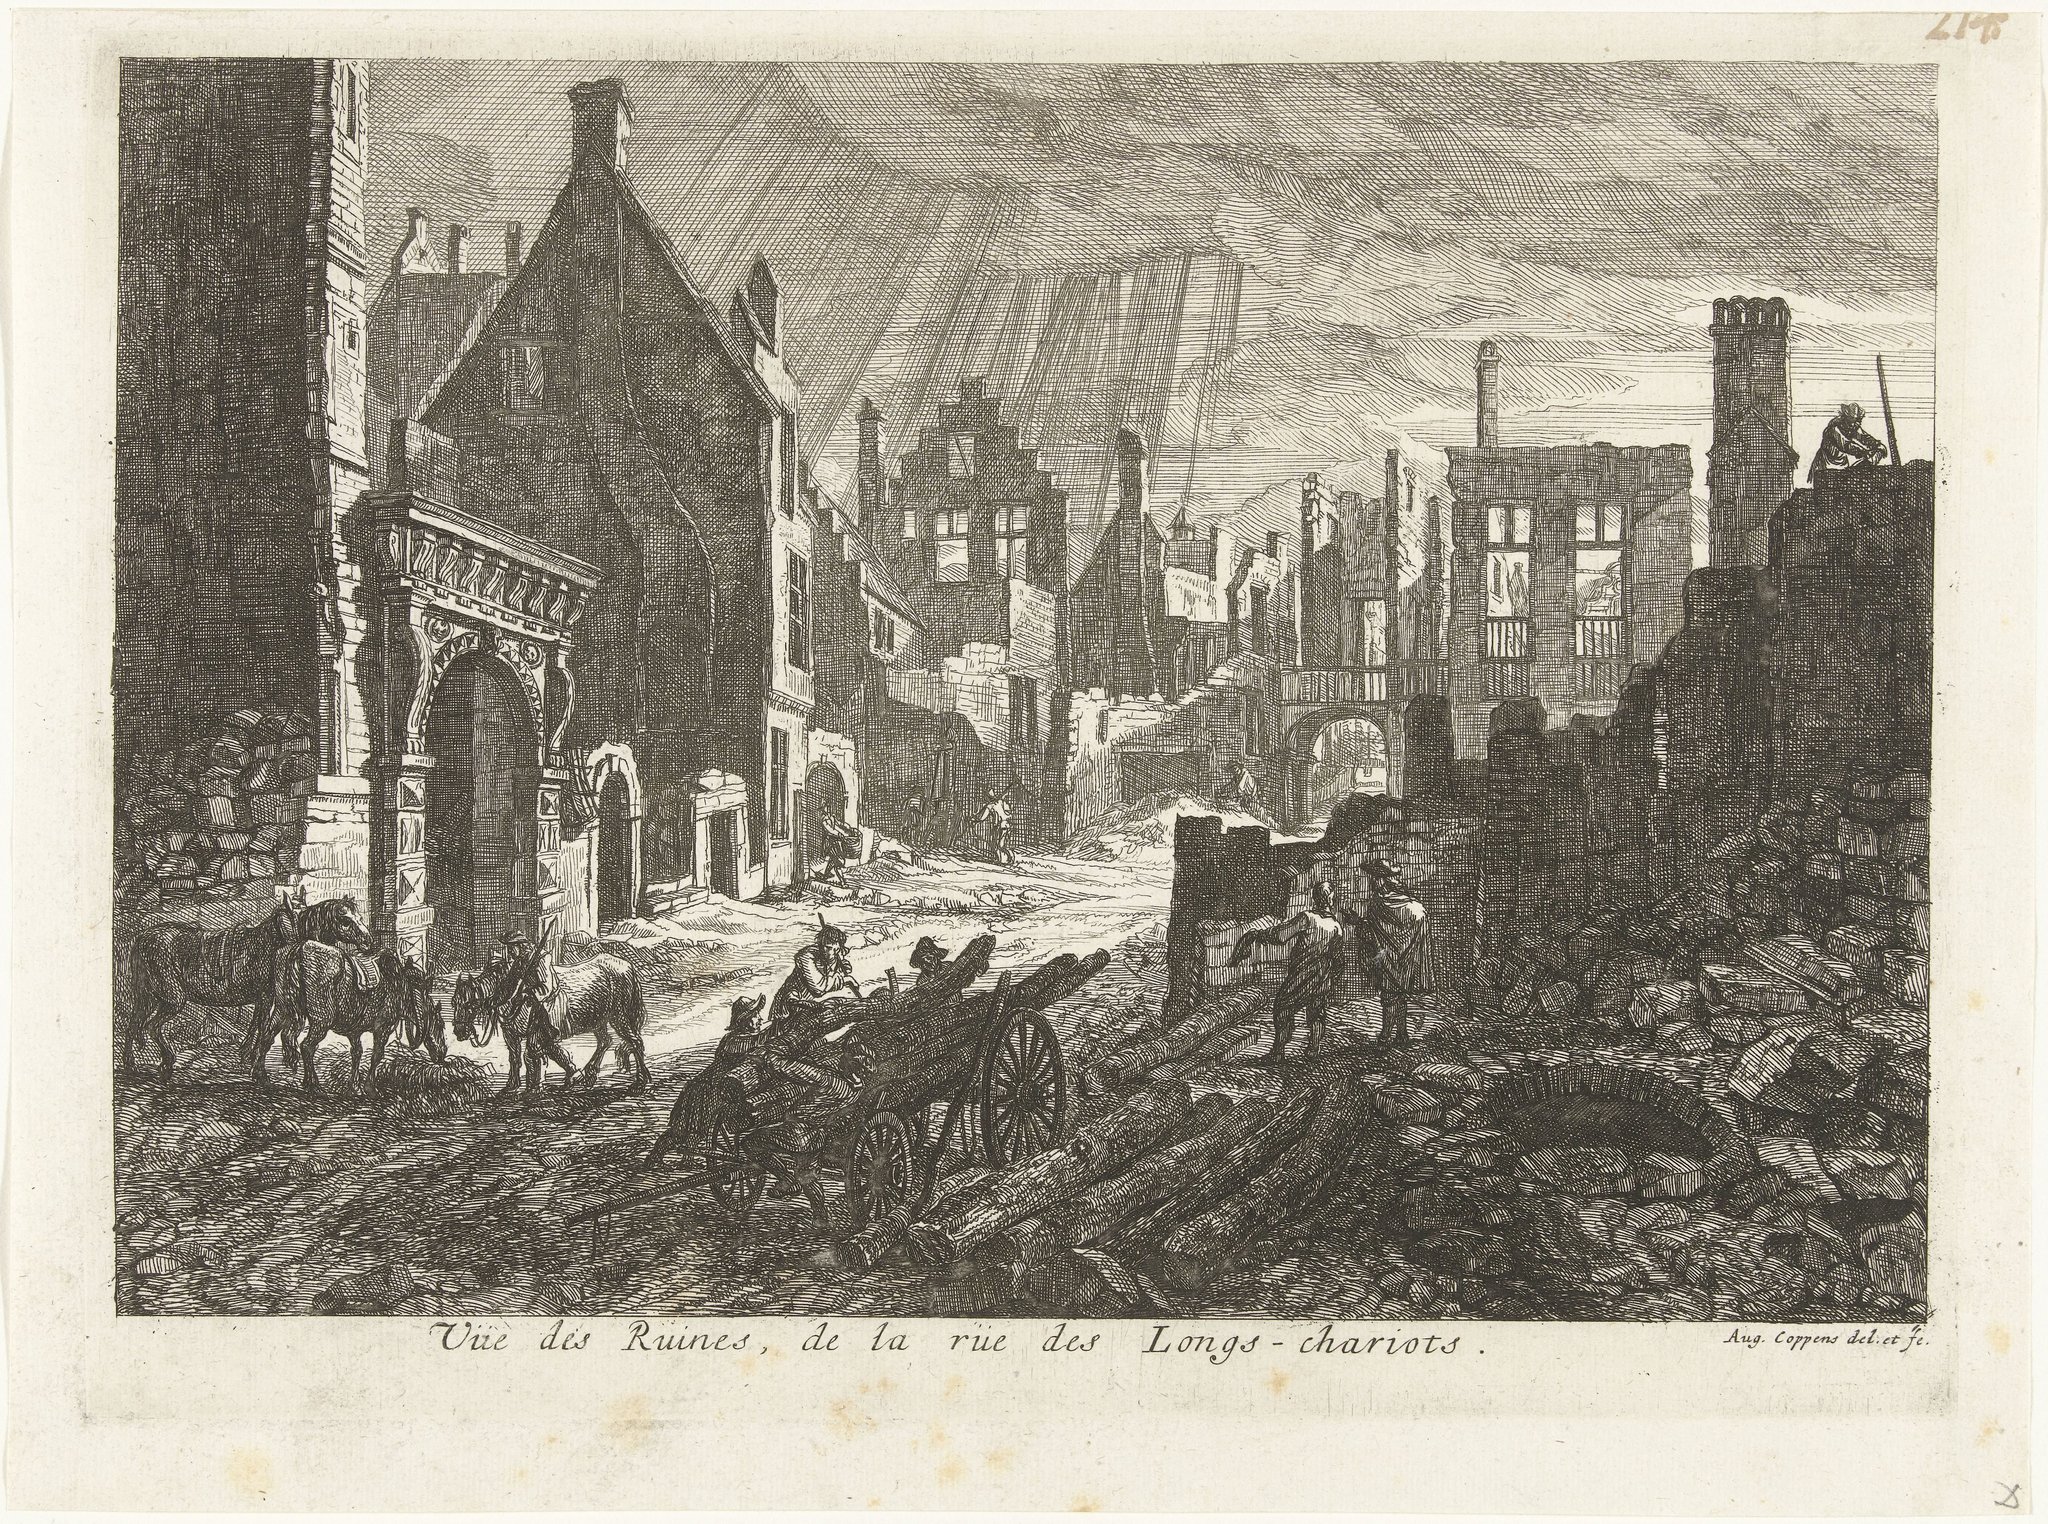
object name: print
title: Vue des Ruines, de la rue des Longs-chariots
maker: augustin coppens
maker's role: print maker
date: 1695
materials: paper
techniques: etching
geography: brussels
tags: devastated, ruined place or city (~ warfare), brussels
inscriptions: collector's mark: Lugt 2228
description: Voorstelling van de ruïnes in de Wagenstraat (?) te Brussel na het bombardement door de Fransen, 13-15 augustus 1695. Achtste prent in een reeks van twaalf.